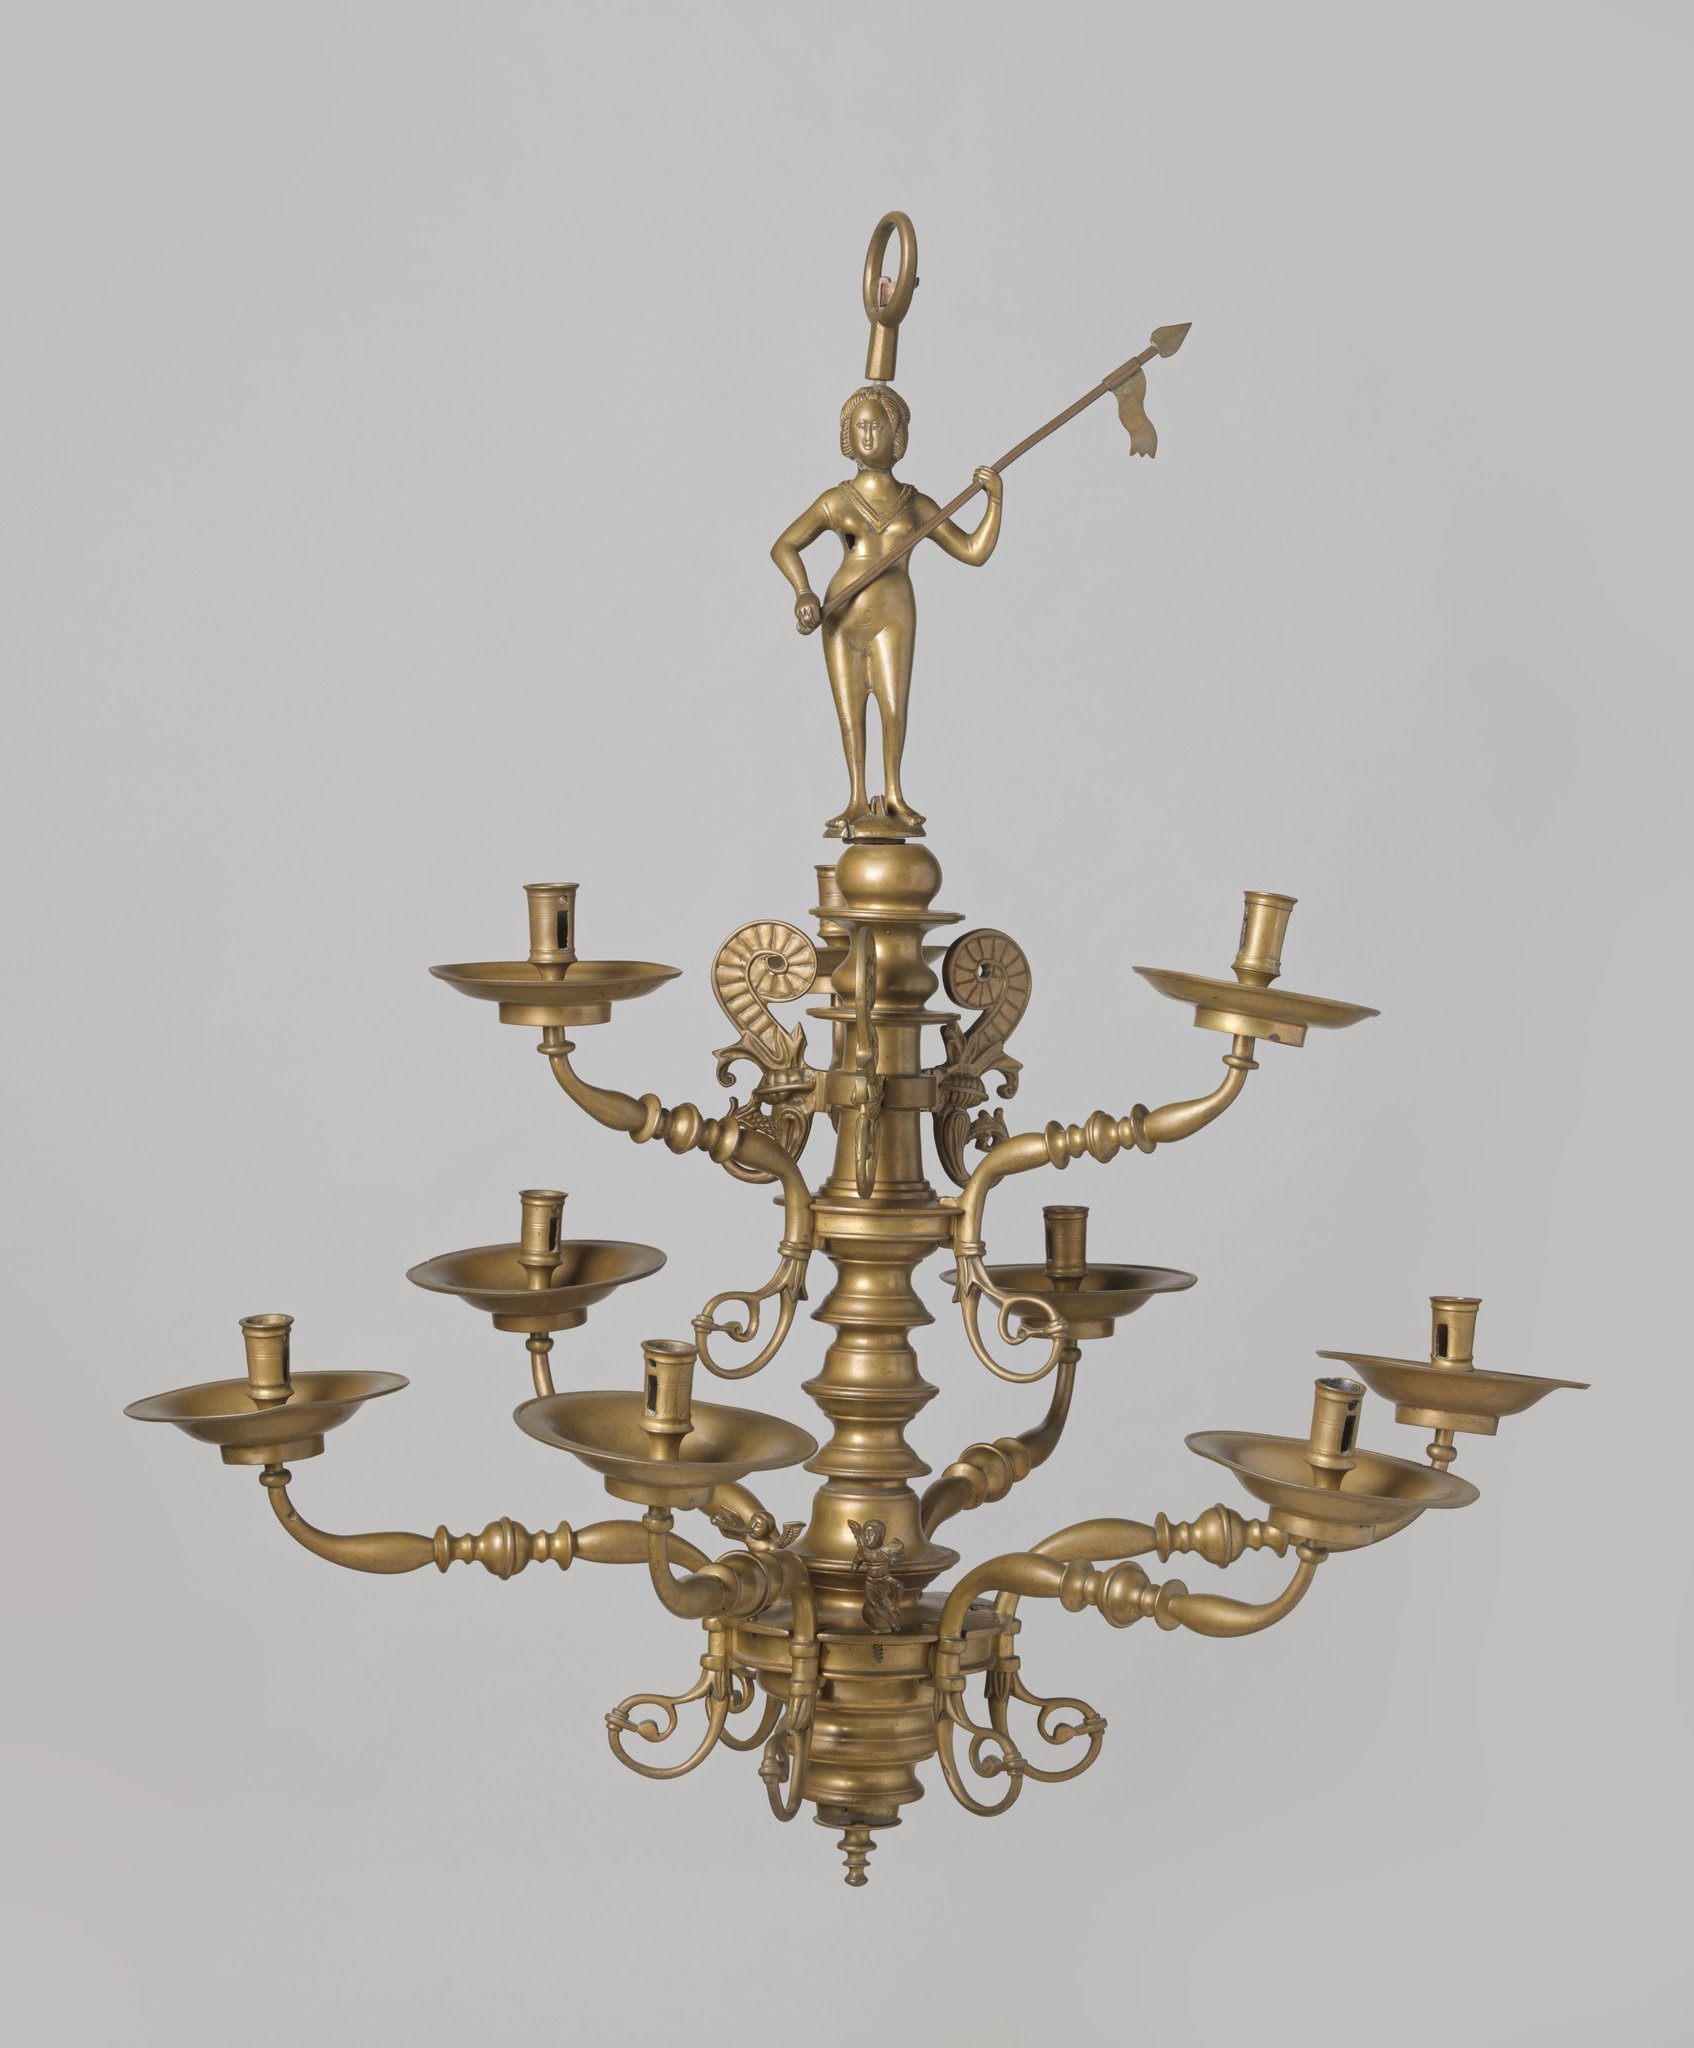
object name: chandelier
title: Arm met kaarsenhouder van kaarsenkroon van twee hoogten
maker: Anonymous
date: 1525-1575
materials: brass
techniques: casting, screwed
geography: lübeck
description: Kaarsenarm behorende bij een kaarsenkroon van twee hoogten met naakte vrouw bovenaan. De arm heeft in het midden een bol- en holrond geprofileerde nodus en verdikt zich een weinig aan weerszijden. Bij de stam loopt zij uit in een spiraalvormige krul. Naar buiten toe mondt zij uit in het schroefeind van ijzer. Daarop bevindt zich de ronde vetvanger met onderaan een afstaande rand. De ronde in elkaars verlengde opengewerkte kaarsenhouder heeft een holronde voet, die op de arm is geschroefd. Dit is de eerste arm van de onderste ring, genummerd met 3 ruitvormige punten. De kaarsenhouder is ongenummerd.